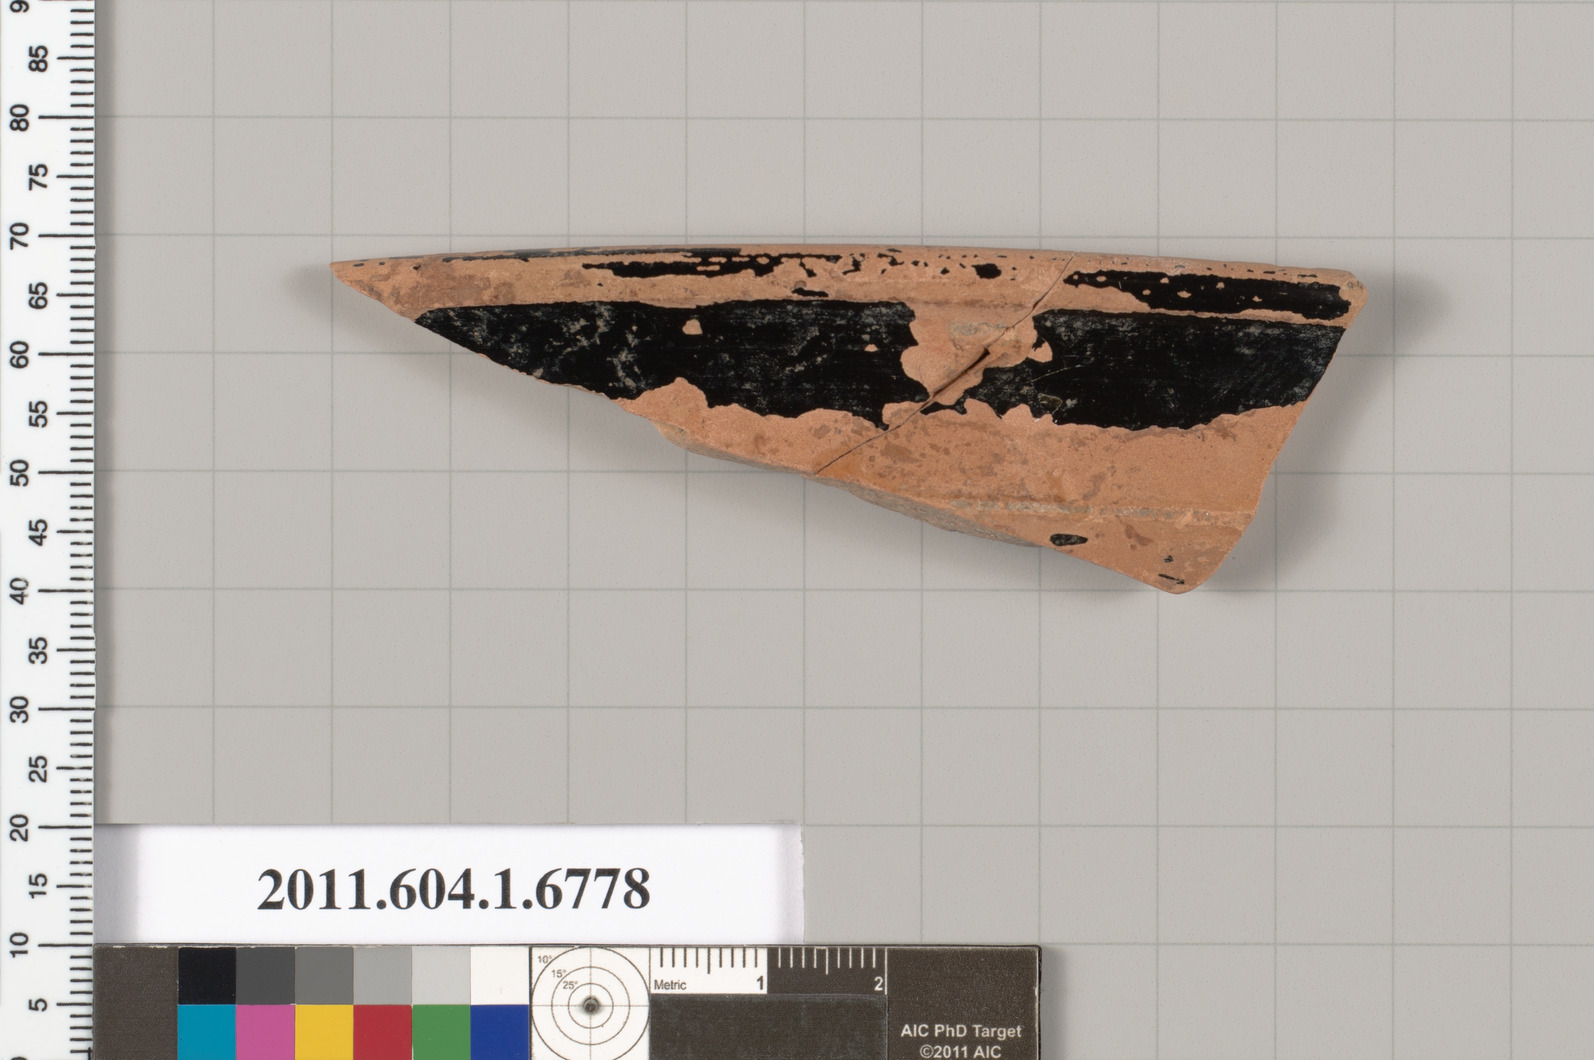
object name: kylix fragment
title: Terracotta fragment of a kylix (drinking cup)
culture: greek, attic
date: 490-470 BCE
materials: terracotta